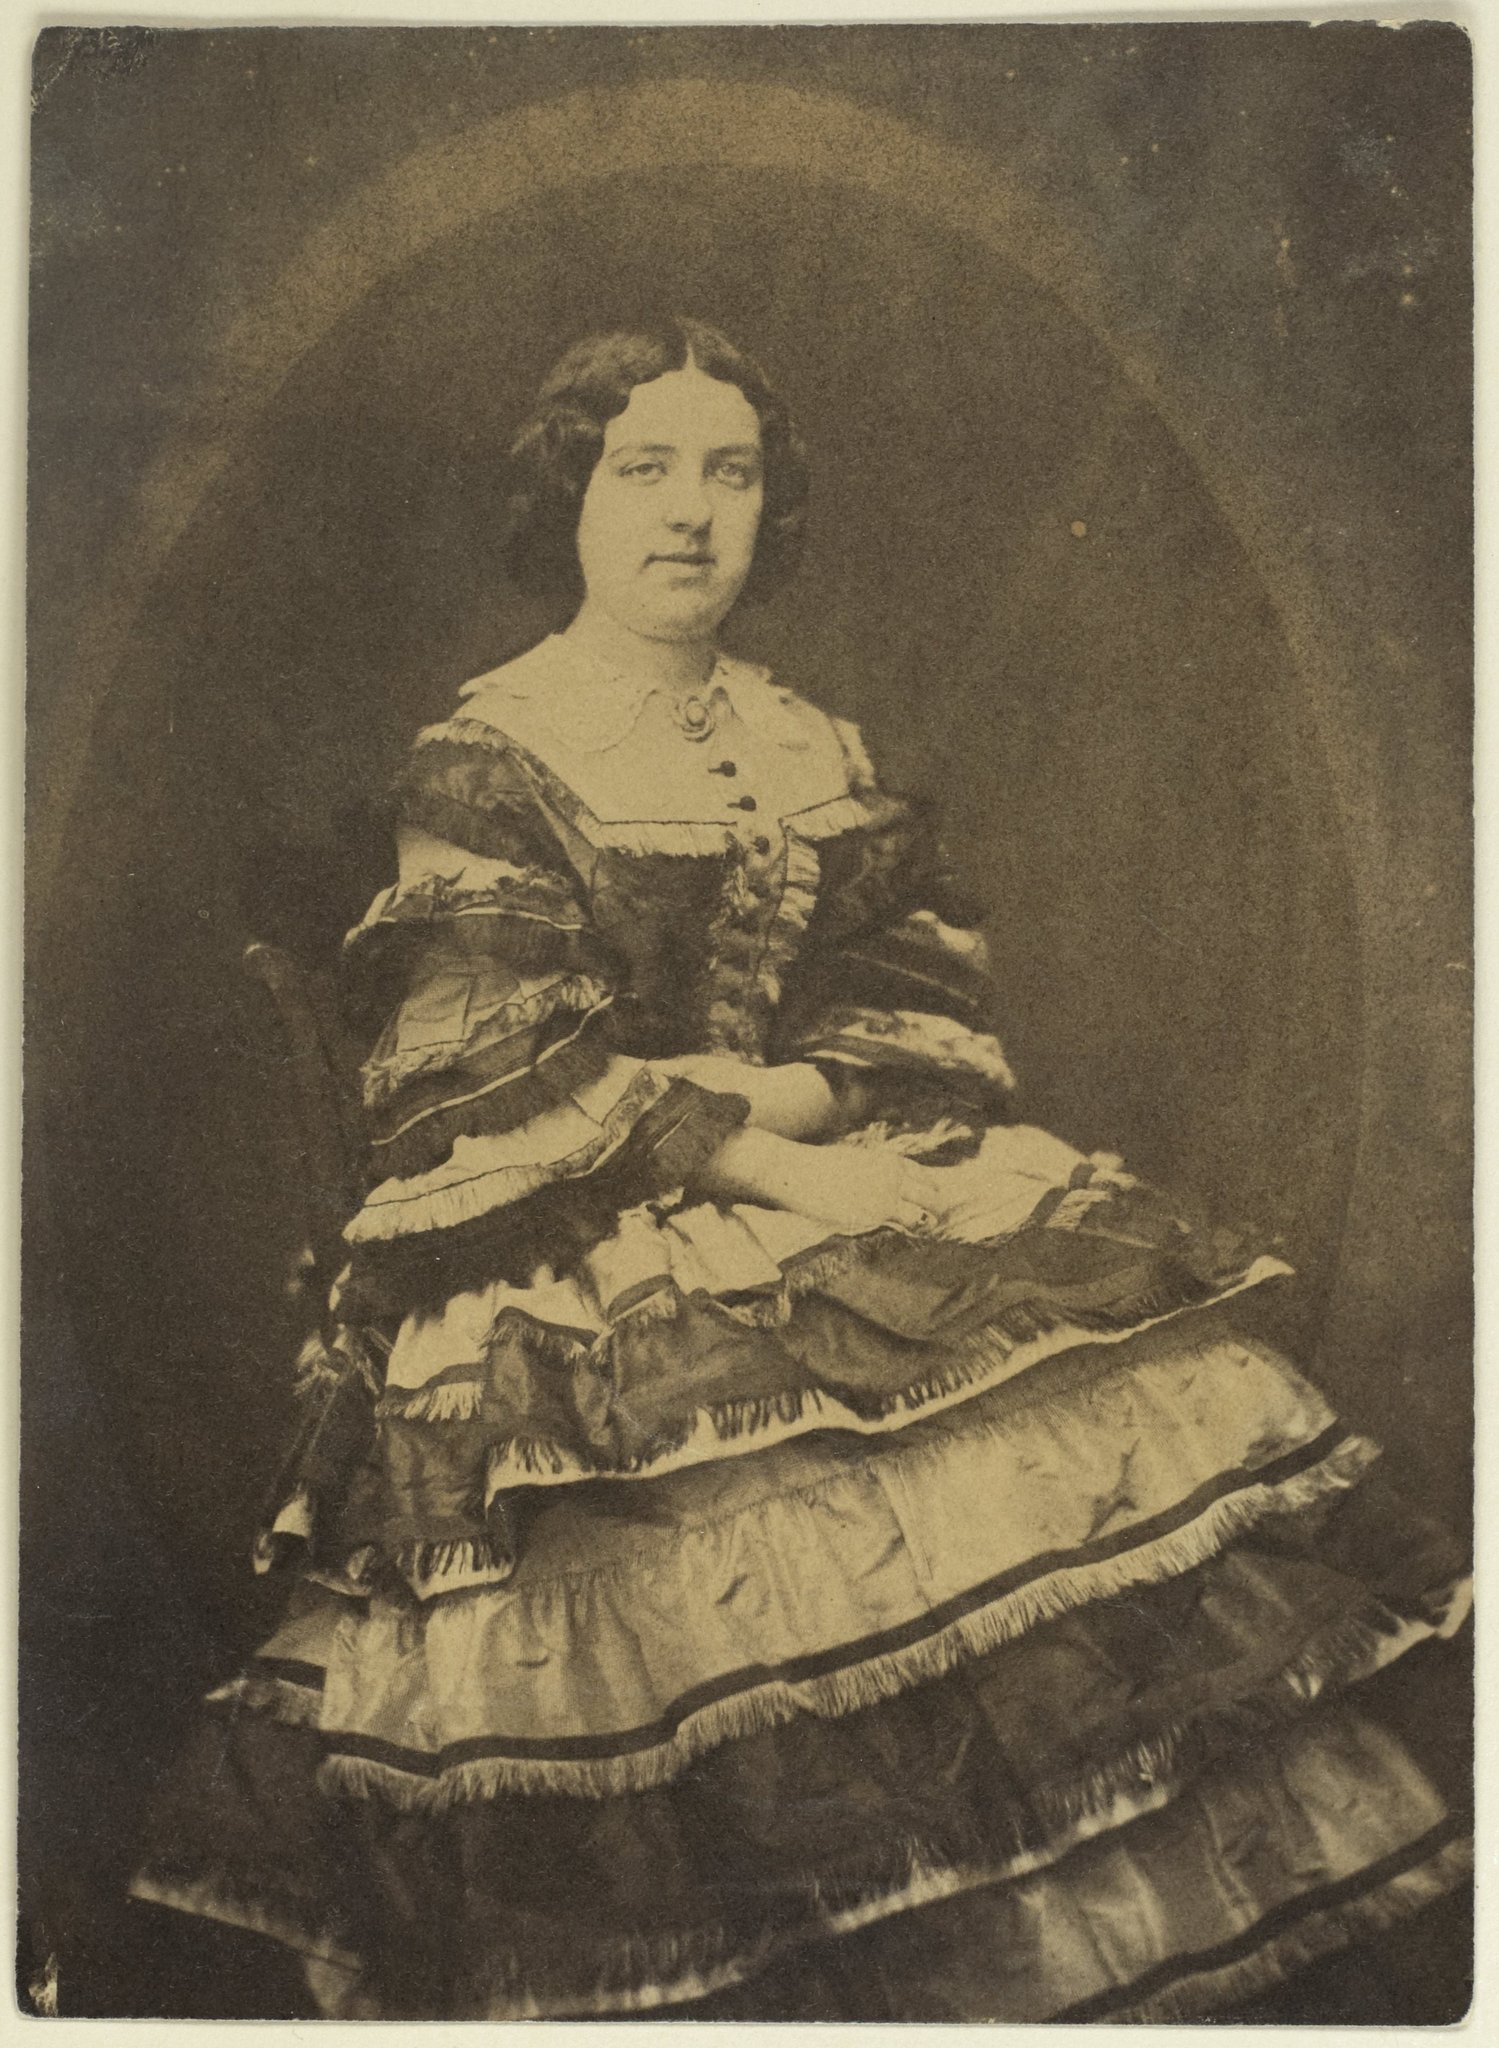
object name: photograph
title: Portret van Charlotte Asser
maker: eduard isaac asser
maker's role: amateurfotograaf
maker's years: 1809-1894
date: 1854-1855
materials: cardboard, paper, photographic support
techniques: salted paper print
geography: amsterdam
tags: brussels, historical persons - bb - woman